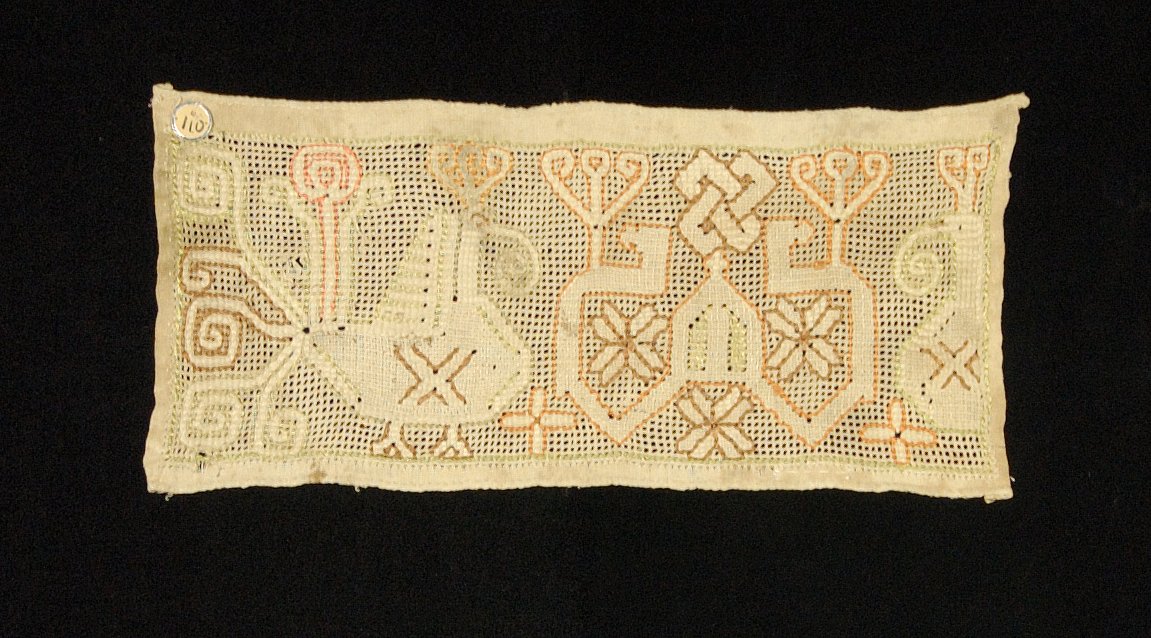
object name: border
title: Towel border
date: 1800-1850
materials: linen, silk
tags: birds